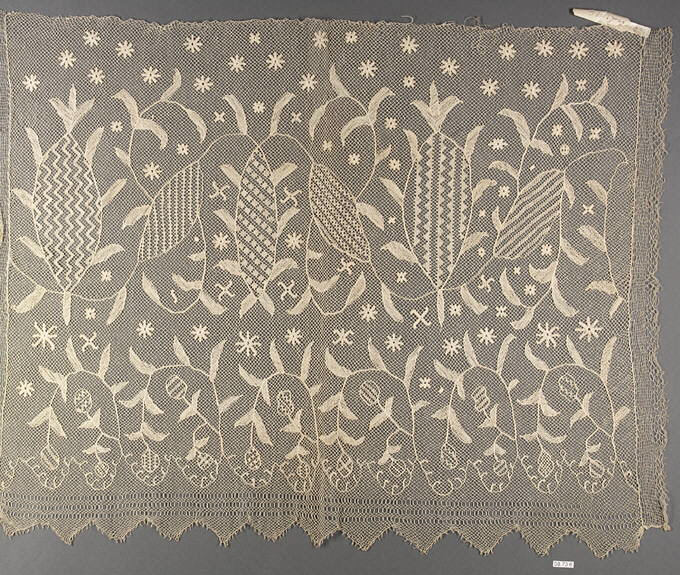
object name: fragment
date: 1801-1900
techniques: embroidery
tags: leaves